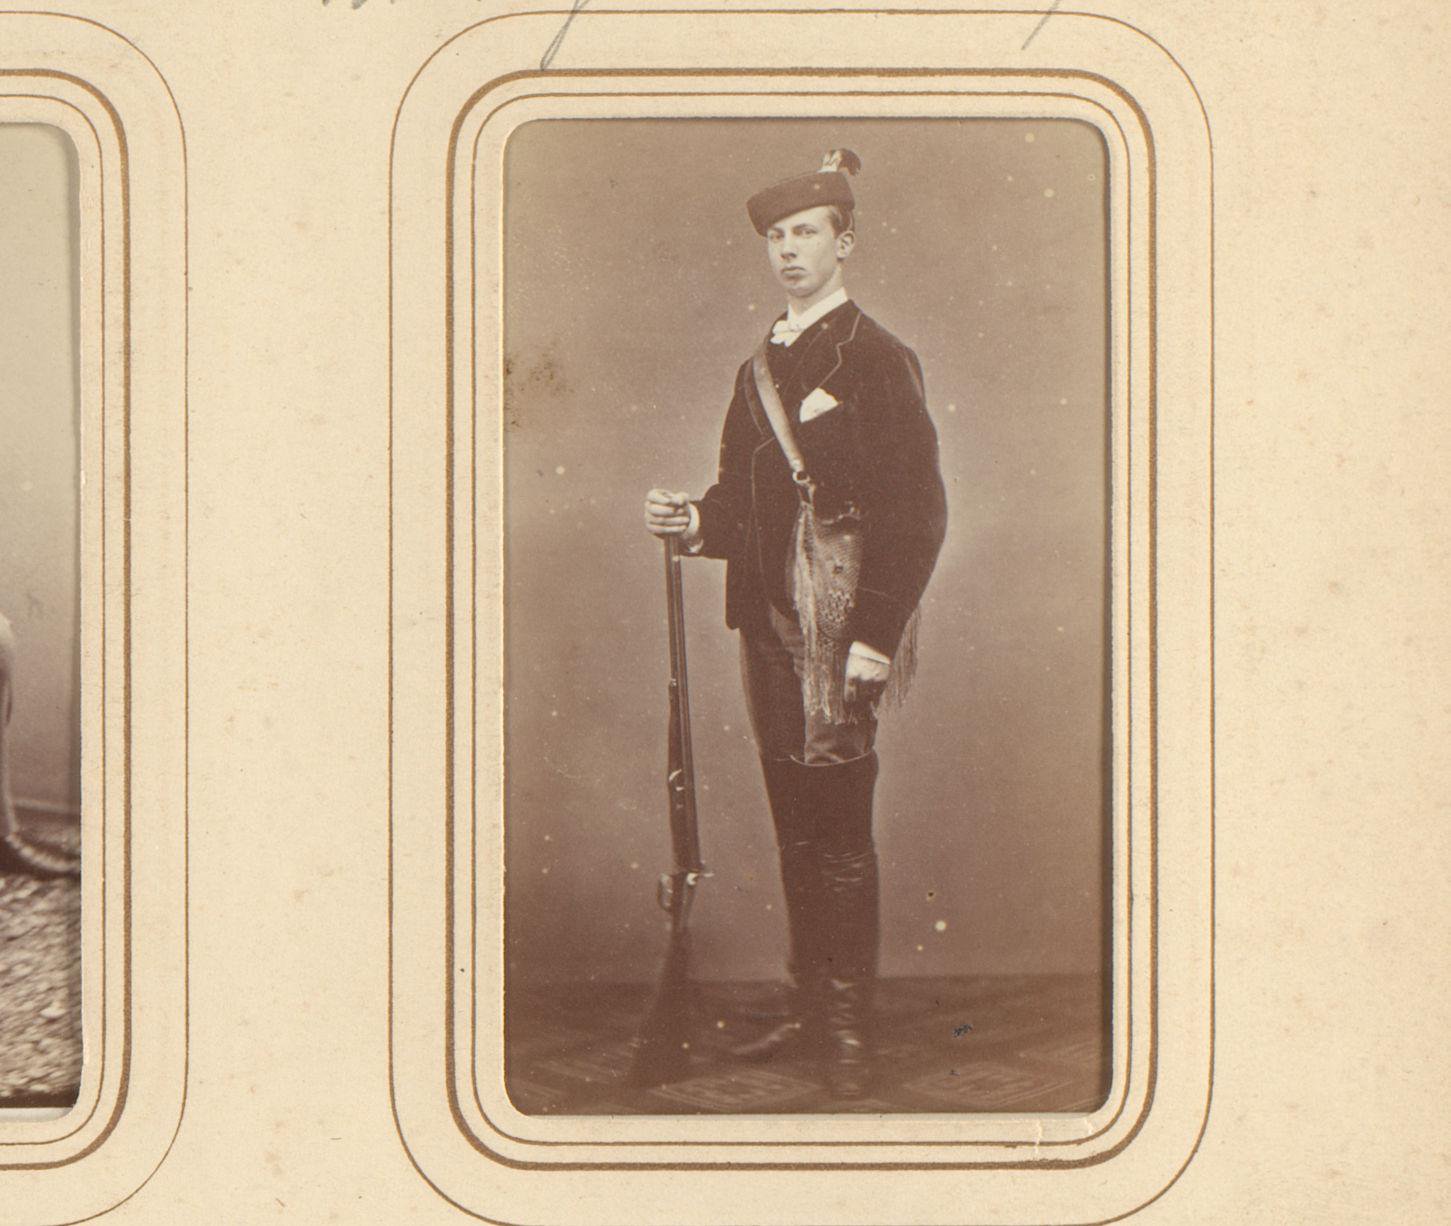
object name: album leaf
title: Portret van een man in jagerskostuum met een jachtgeweer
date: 1860-1880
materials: cardboard, photographic support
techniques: albumen print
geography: netherlands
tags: adult man, firearms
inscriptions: inscription: ‘Photogr. Atelier / Wegner & Mottu / Kalverstraat / over den Heyligenweg, D. 26. /Amsterdam / Leydsche Straatweg / Buiten Cathrynen. / Utrecht’